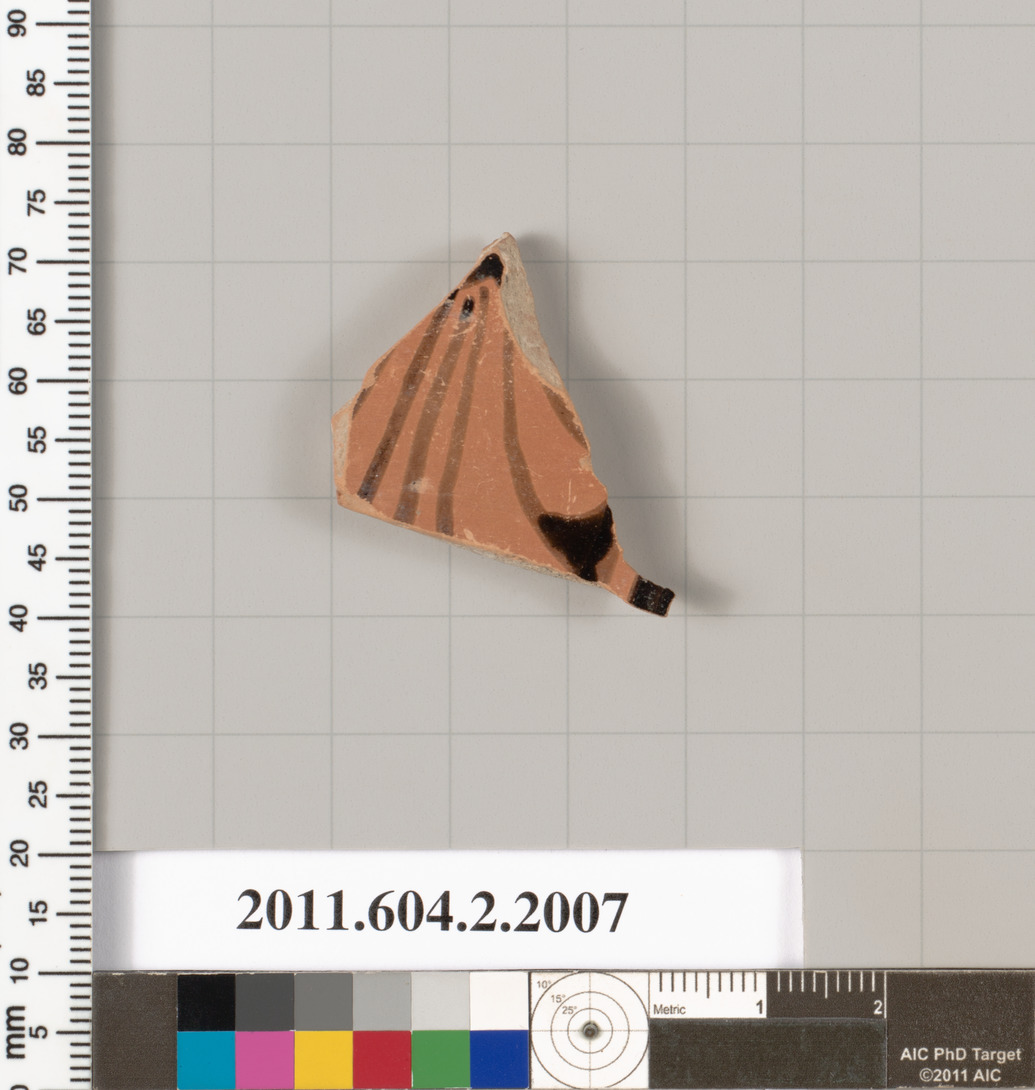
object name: pot fragment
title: Terracotta fragment of a pot; unglazed on the inside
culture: greek, attic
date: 467-435 BCE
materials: terracotta